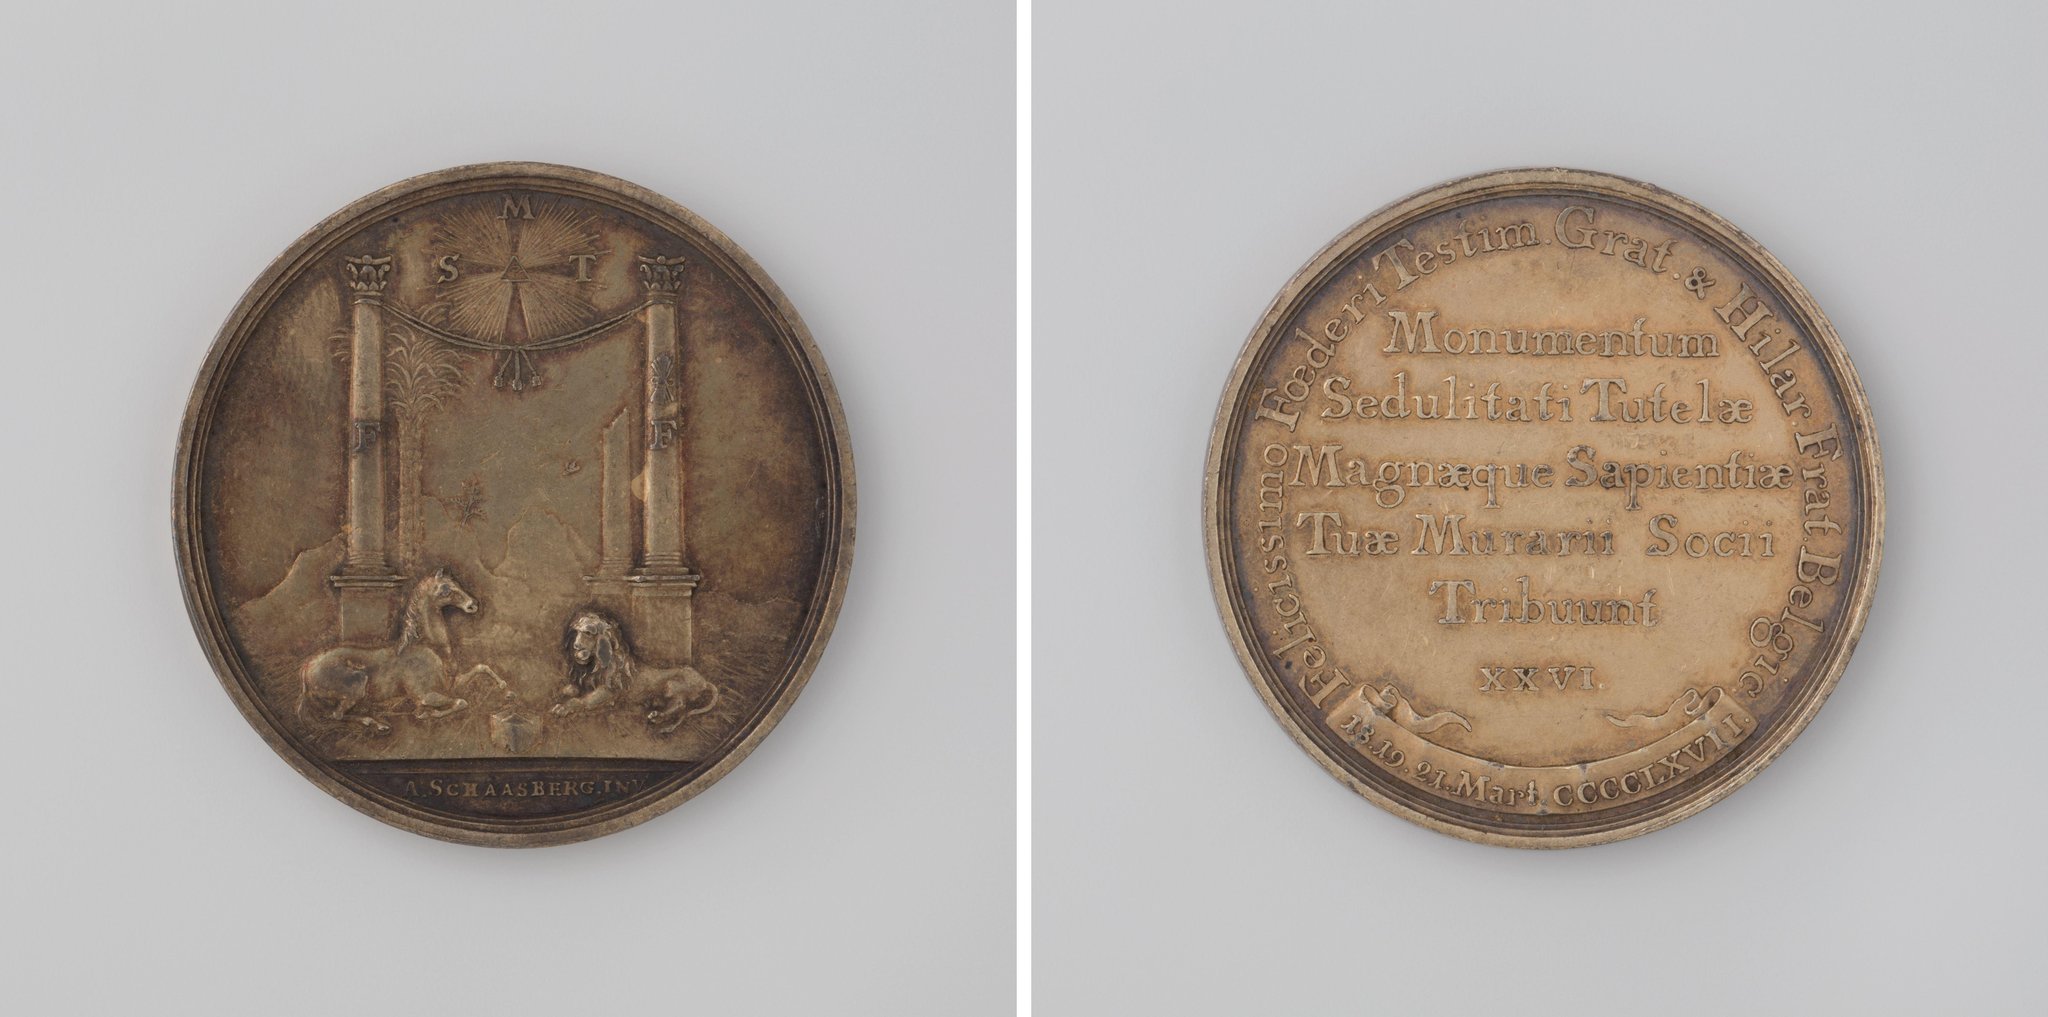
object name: history medal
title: Verbond van vereniging tussen de vrijmetselaarsloge der Strikte Observantie te Brunswijk en het Groot Oosten der Nederlanden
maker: arent schaasberg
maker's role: draughtsman, painter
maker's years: 1716-1809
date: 1781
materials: silver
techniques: gilding, striking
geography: germany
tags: wolfenbüttel, braunschweig, militair, hertog, veldheer, ferdinand hertog van brunswijk-wolfenbüttel, landgraaf van hessen-kassel frederik